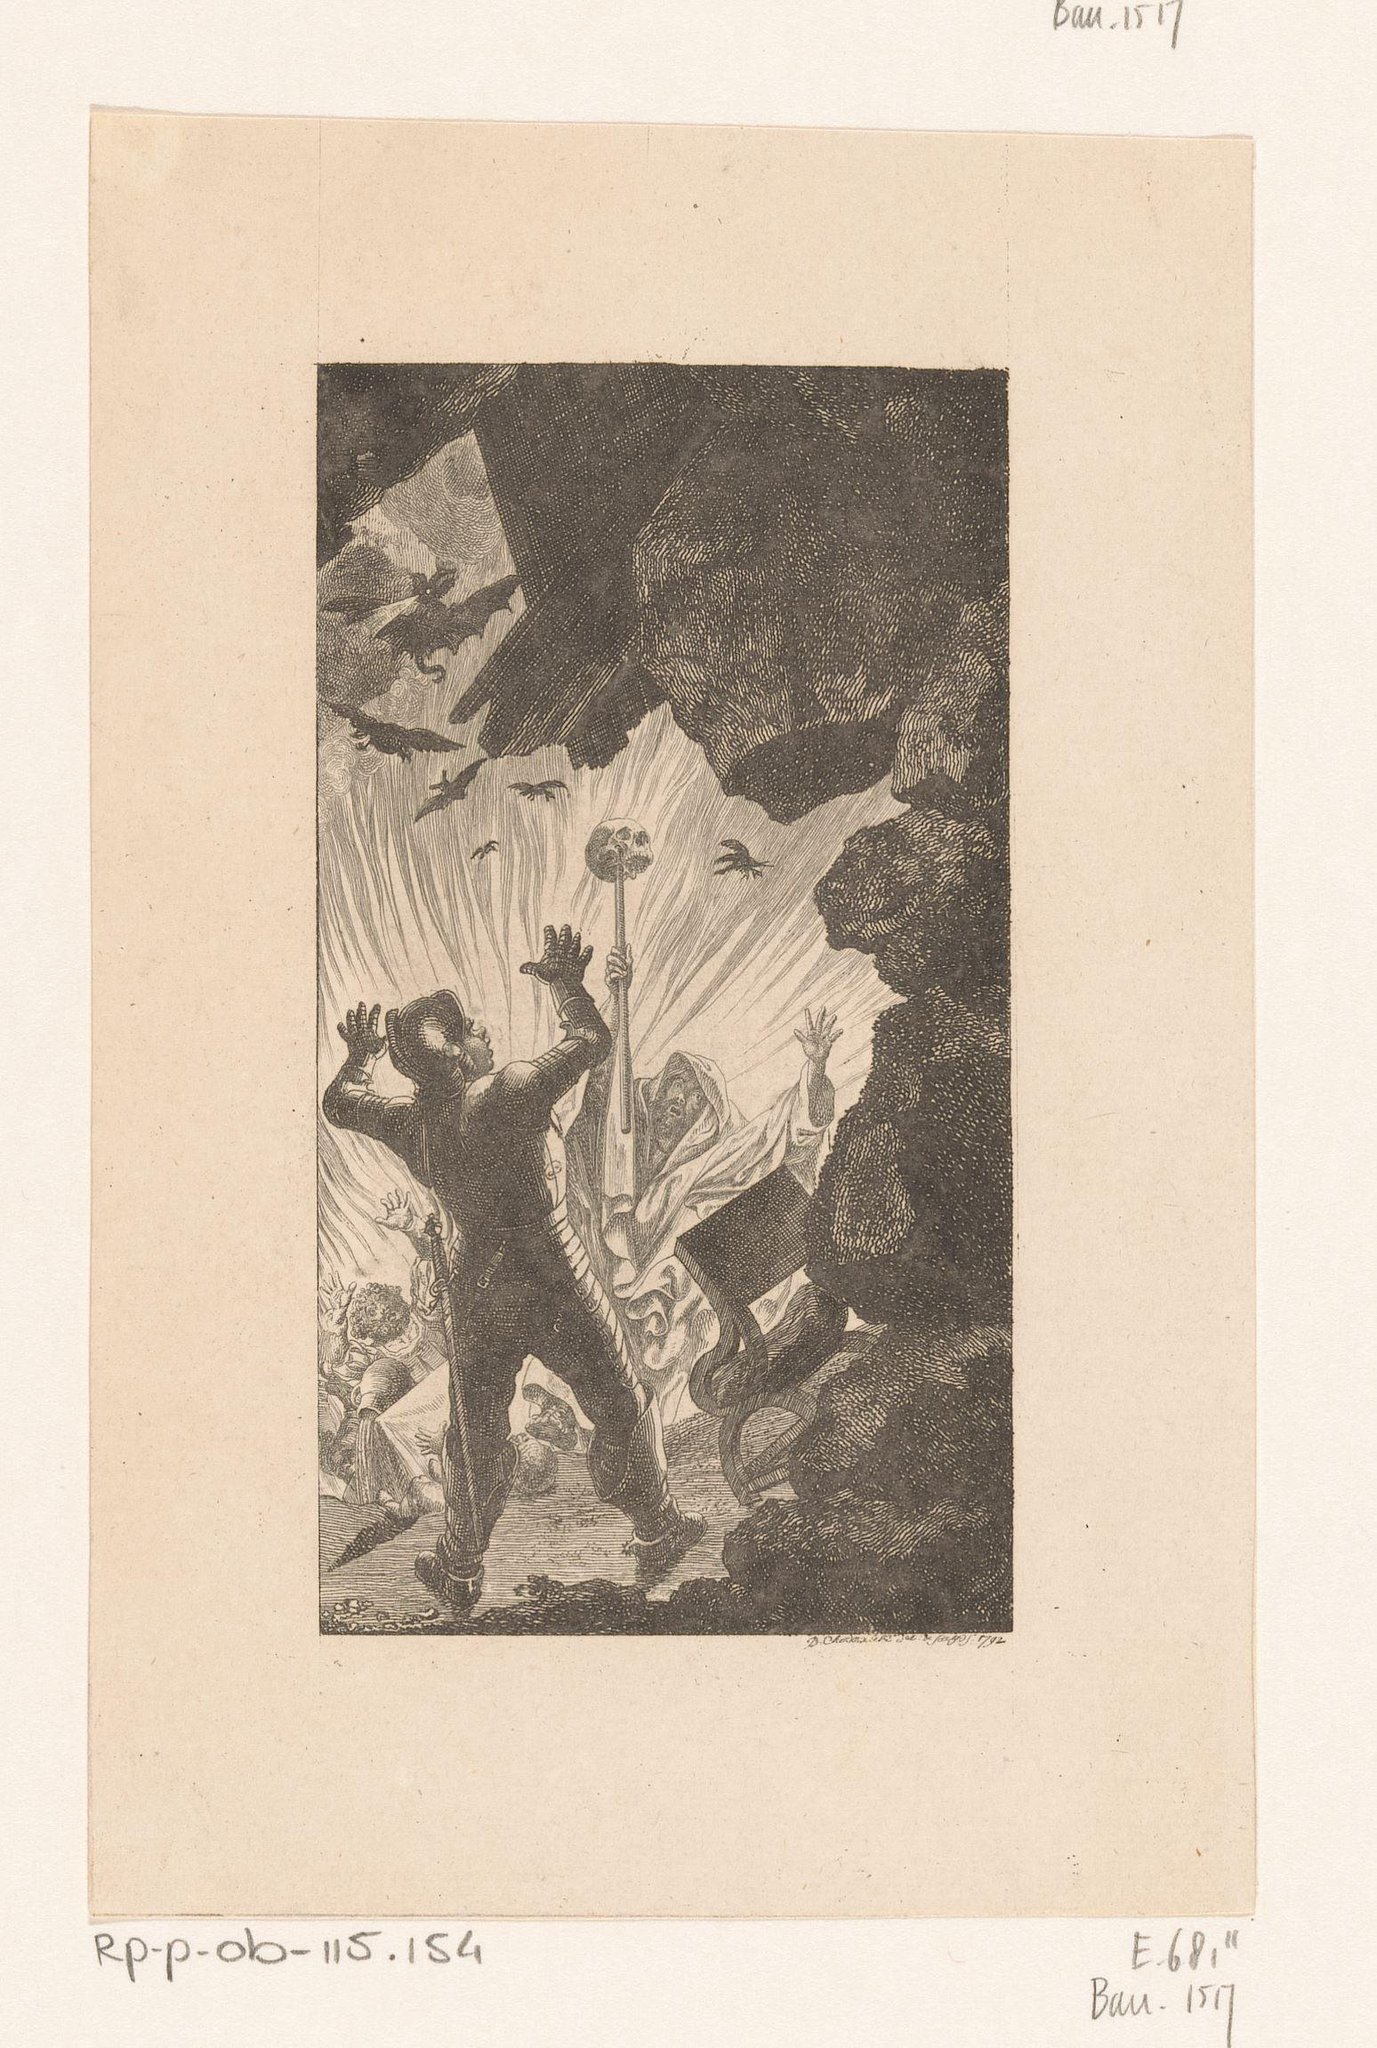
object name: print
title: Wenzel von Tollenstein schrikt van een vurige geestverschijning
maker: daniel nikolaus chodowiecki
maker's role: draughtsman, print maker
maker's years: 1726-1801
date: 1792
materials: paper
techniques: etching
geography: berlin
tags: alarm, fright; 'spavento', 'terrore' (ripa), literature, cave, grotto, death's head, skull (symbol of death)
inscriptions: collector's mark: Lugt 2228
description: Prent gebruikt voor: Langbein, August Friedrich Ernst. Schwaenke von A. F. E. Langbein. 2 dln. Dresden en Leipzig: Richterschen Buchhandlung, 1792, dl. 2.